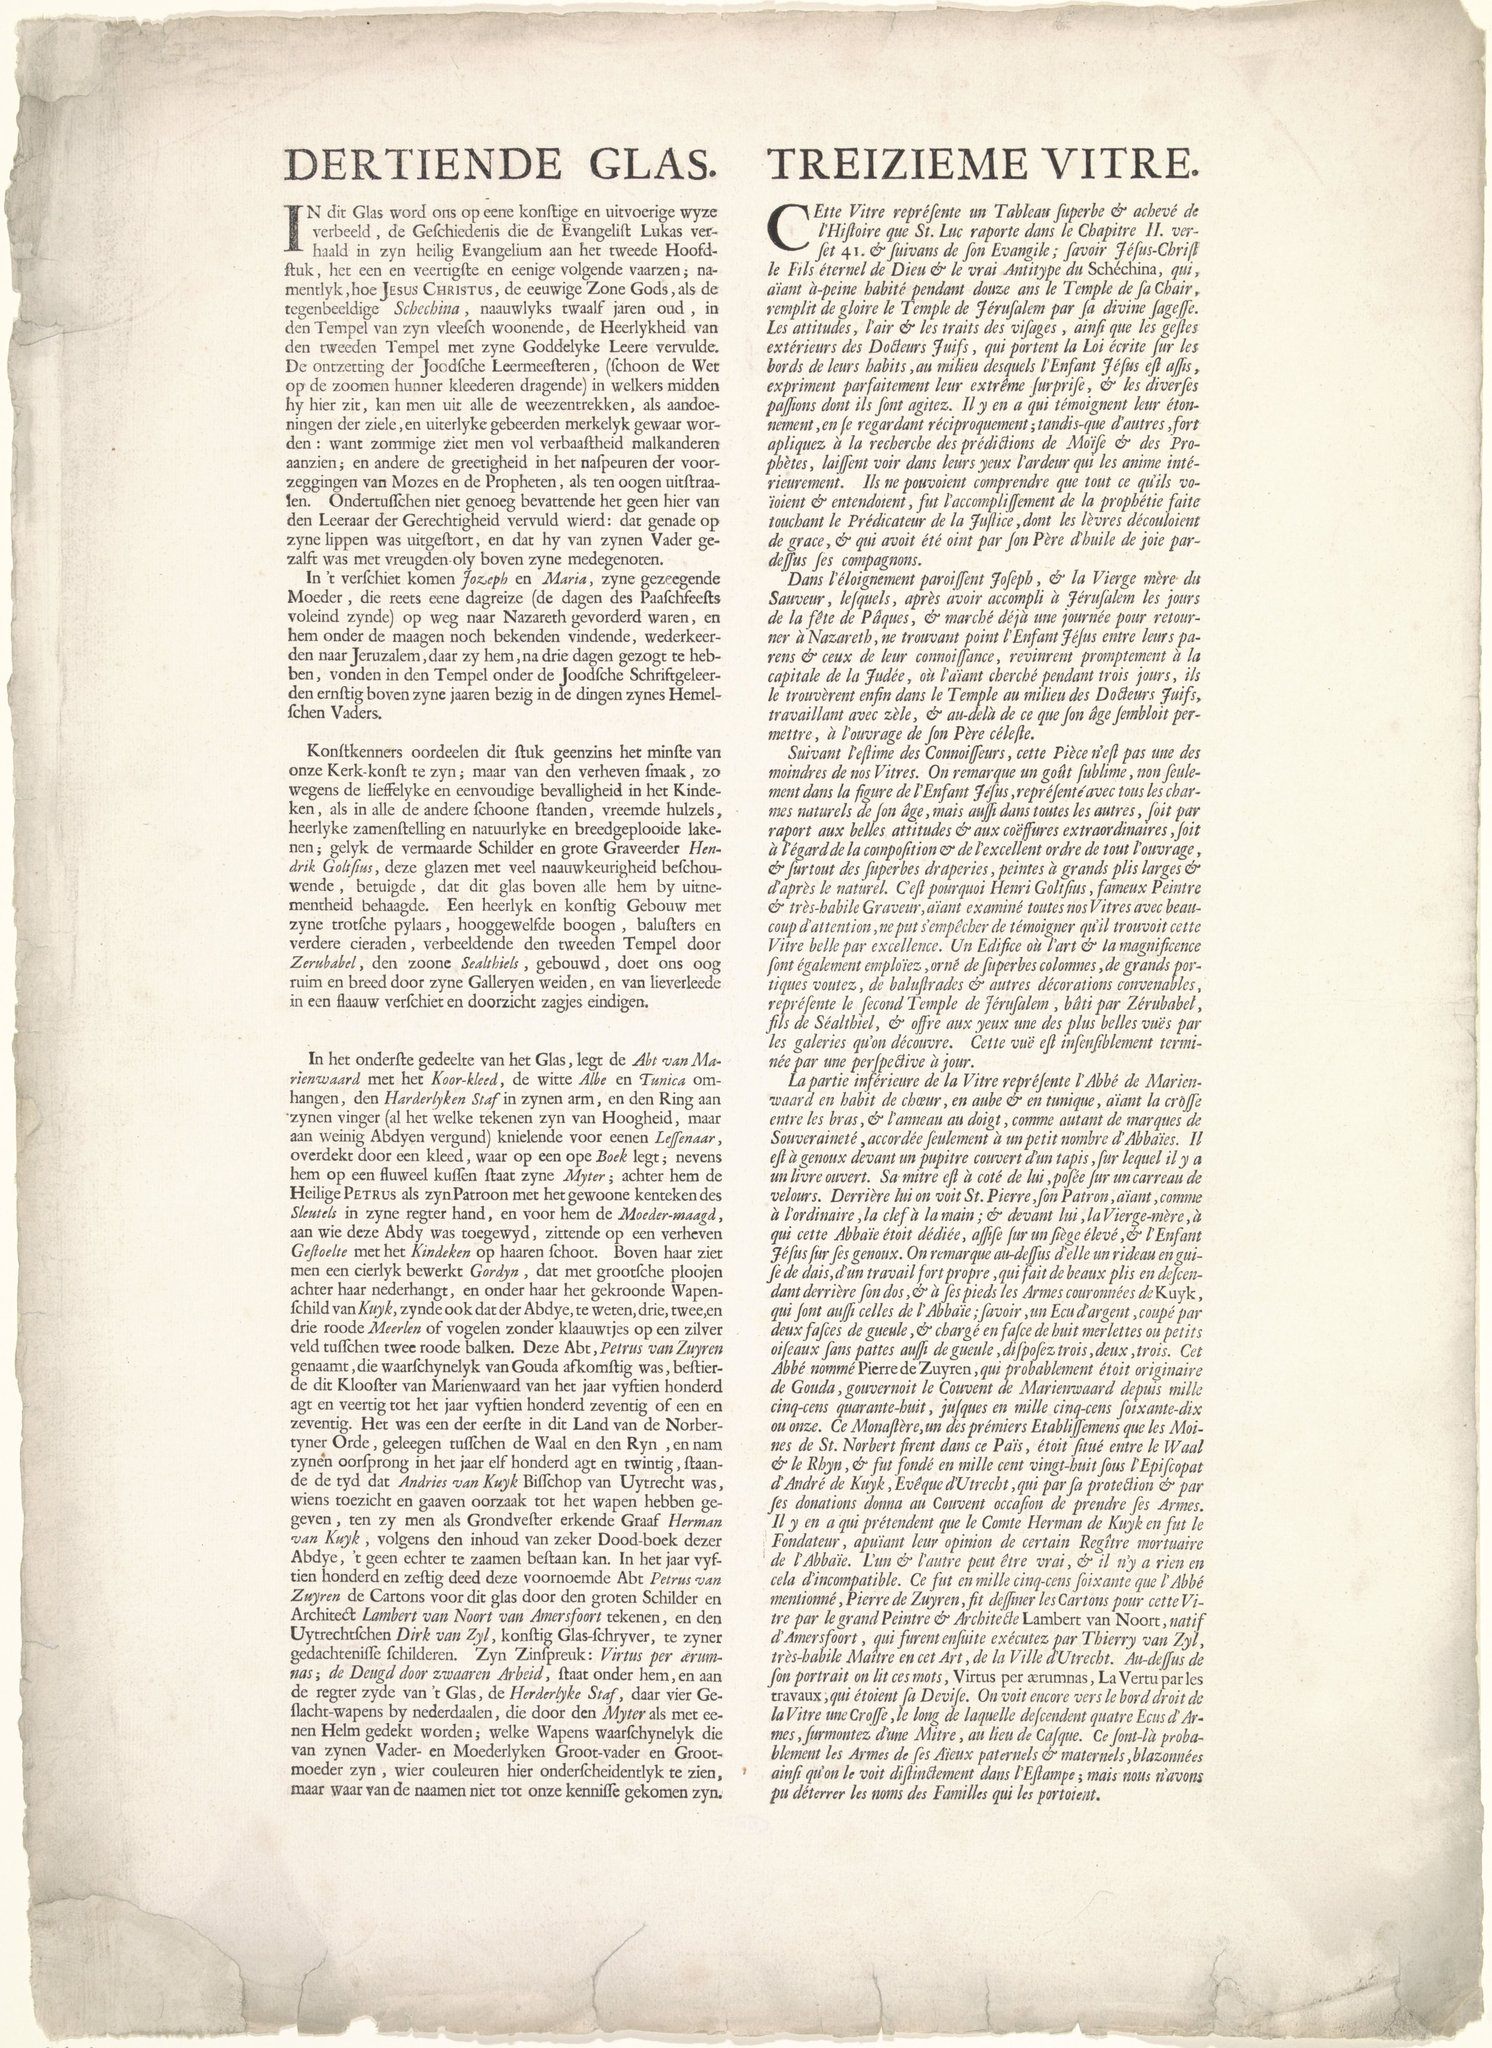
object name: text sheet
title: Tekstblad bij het dertiende glasraam in de Sint-Janskerk Gouda: De twaalfjarige Christus in de tempel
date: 1738-1754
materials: paper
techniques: letterpress printing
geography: amsterdam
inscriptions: collector's mark: Lugt 2228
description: Toelichting bij het door Pieter Tanjé in prent gebrachte vijfde glasraam in de Sint-Janskerk Gouda: De twaalfjarige Christus in de tempel. Twee kolommen tekst in het Nederlands en Frans.